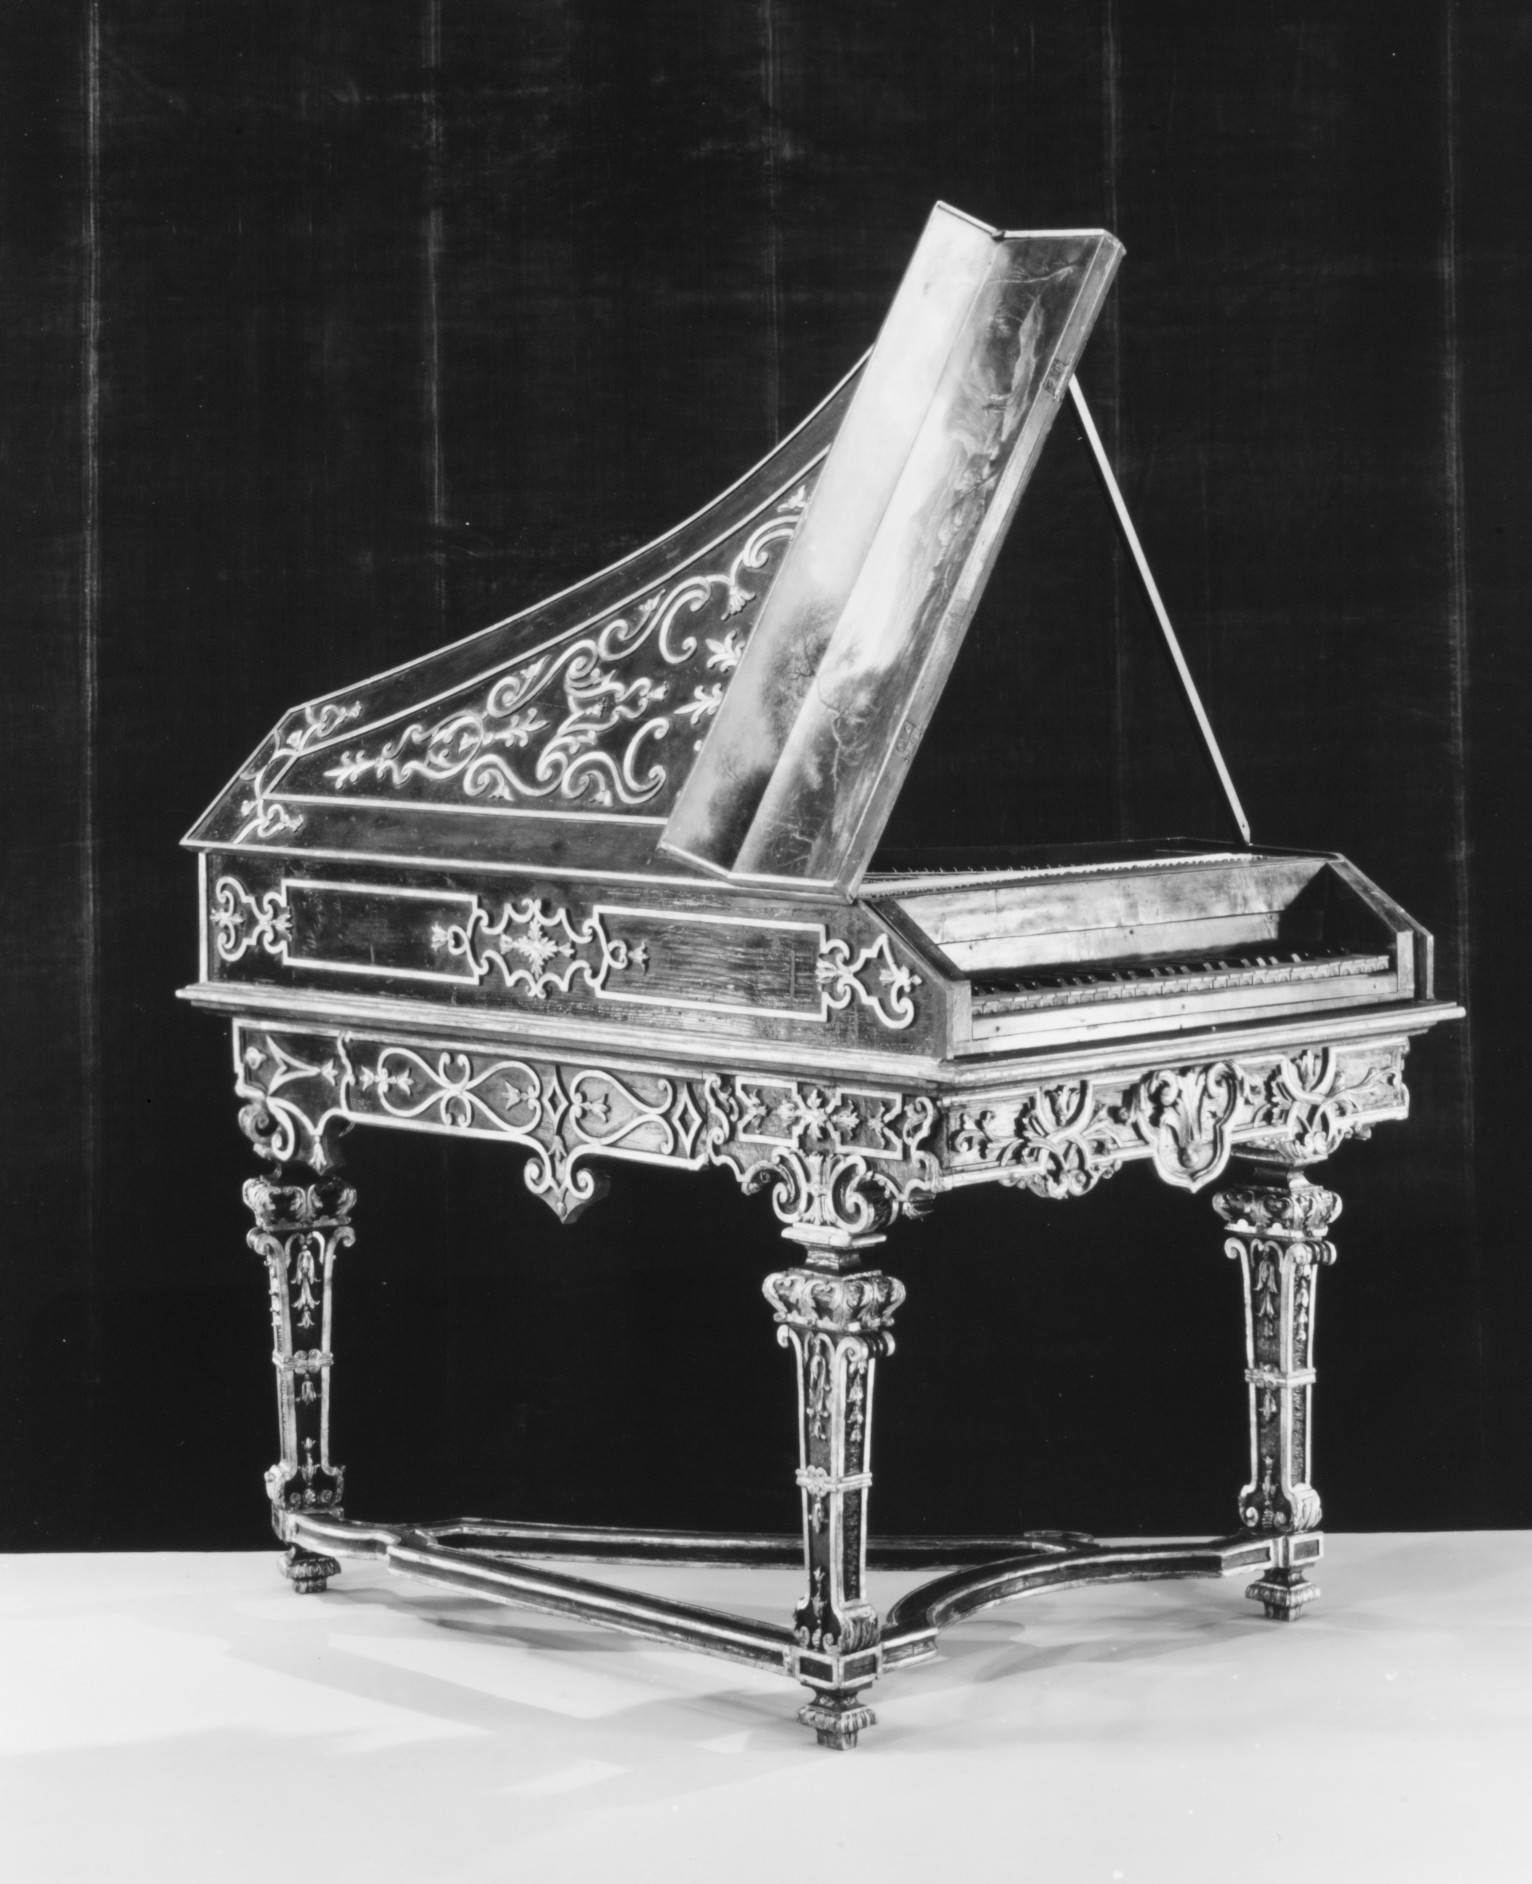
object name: harpsichord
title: Harpsichord (part of a set)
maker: crescenzio onofri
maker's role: artist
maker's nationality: italian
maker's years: 1632-1712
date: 1801-2000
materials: wood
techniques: gilding, painting